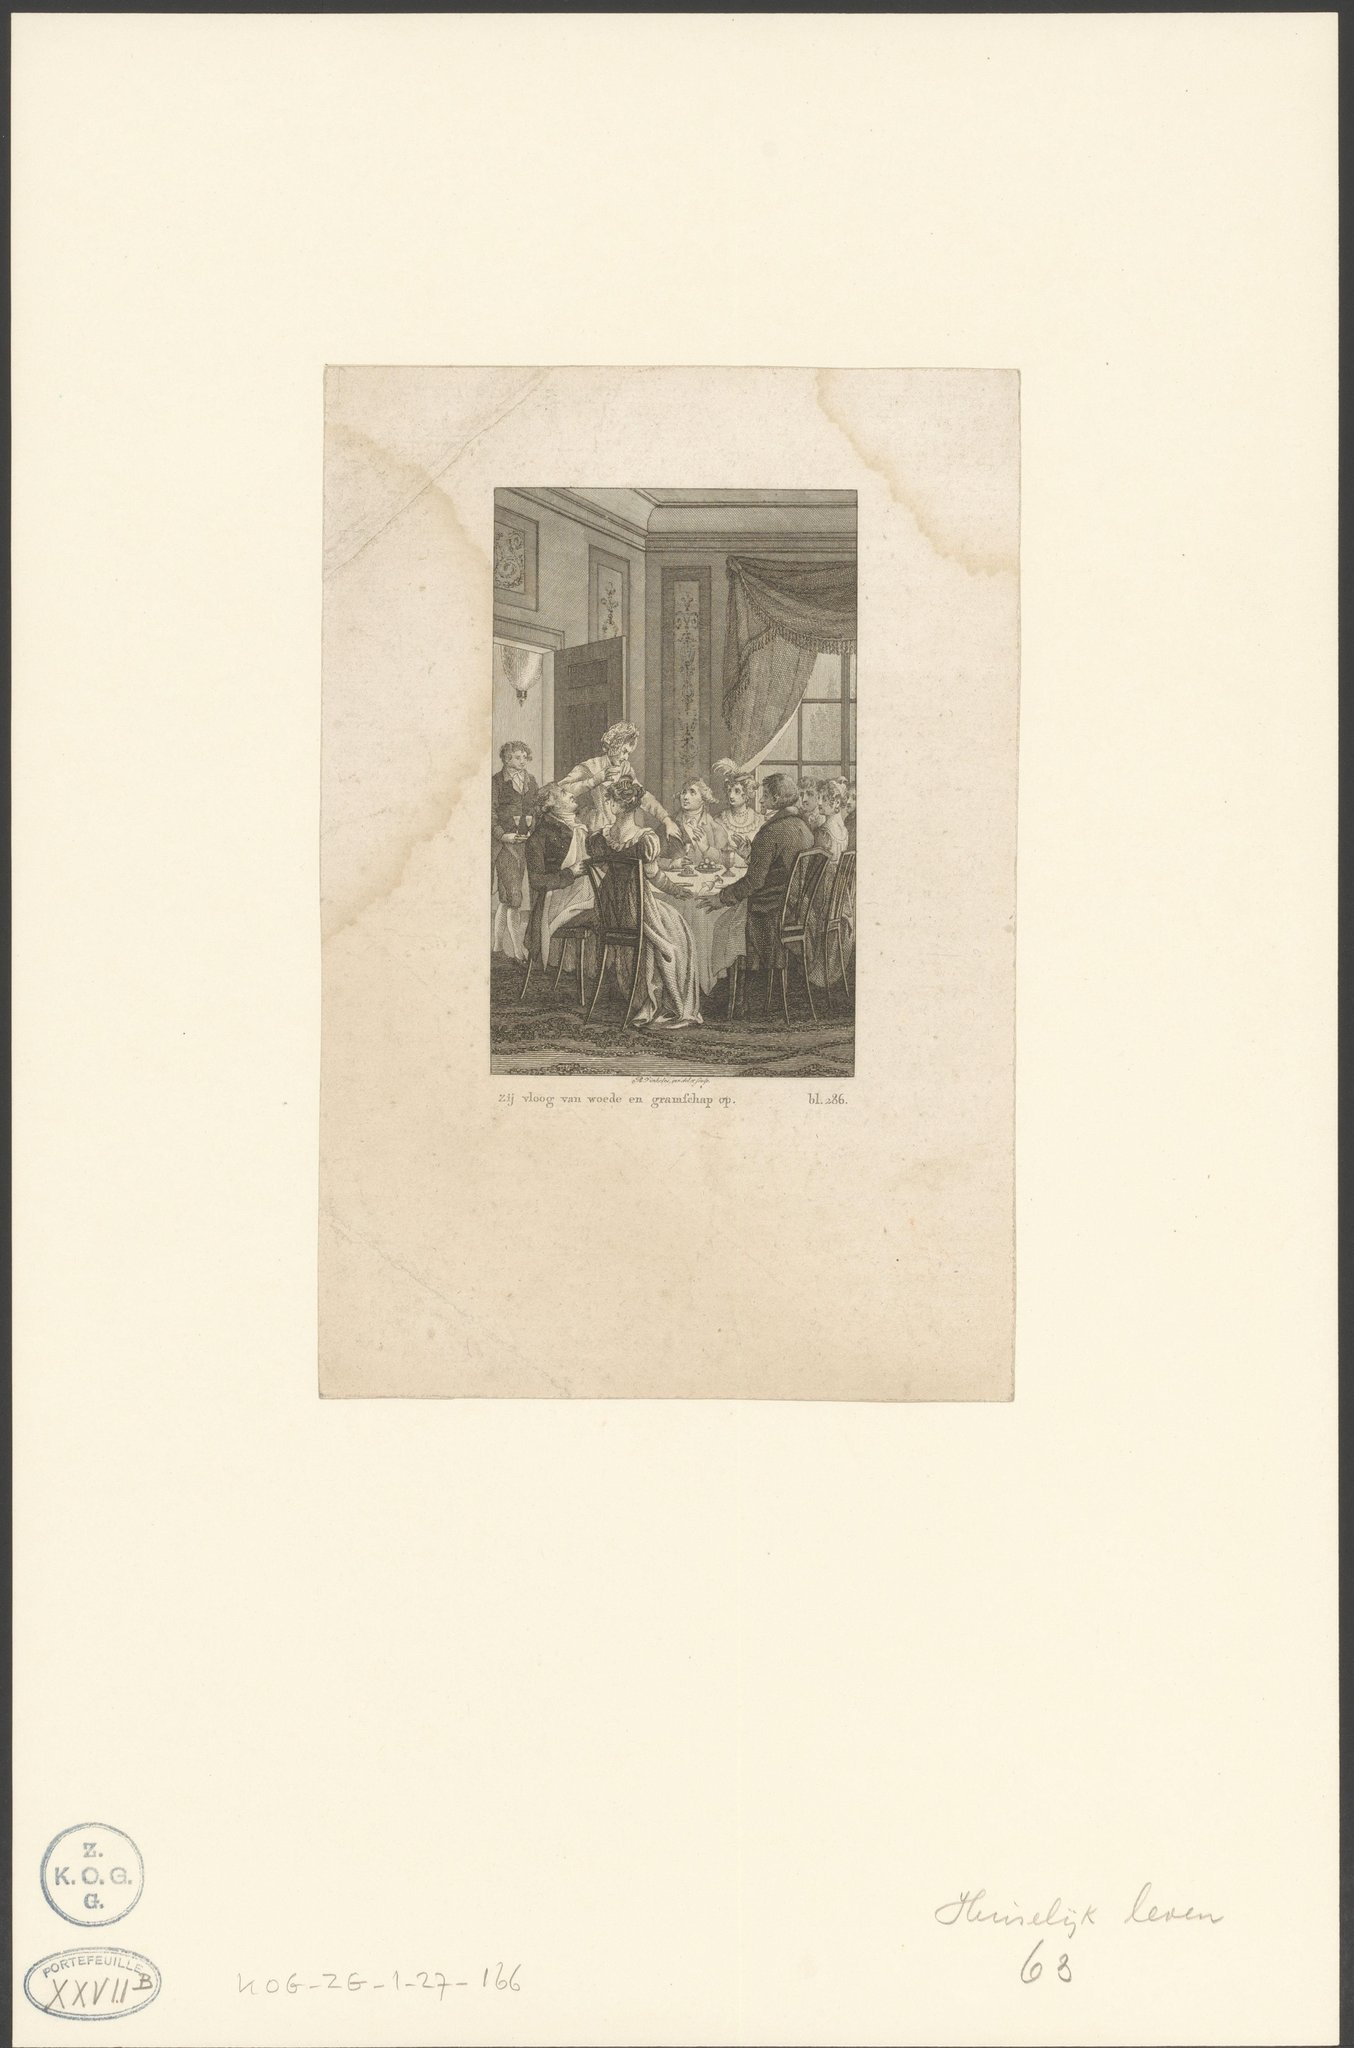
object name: book illustration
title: Zij vloog van woede en gramschap op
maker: reinier vinkeles (i)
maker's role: draughtsman, print maker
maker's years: 1741-1816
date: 1810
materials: paper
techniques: engraving, etching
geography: netherlands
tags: family life at home, evening meal, dinner, supper, dining-room, rage, anger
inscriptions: collector's mark: Lugt 1641, collector's mark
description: Gebruikt als illustratie in: Willem Kist, Eduard van Eikenhorst, zijne Huisgenooten en Vrienden. Door den Schrijver van den Ring van Gijges wedergevonden. Eerste Deel (Tweede druk). Met Platen. Haarlem: F. Bohn, 1810, p. 286/287.